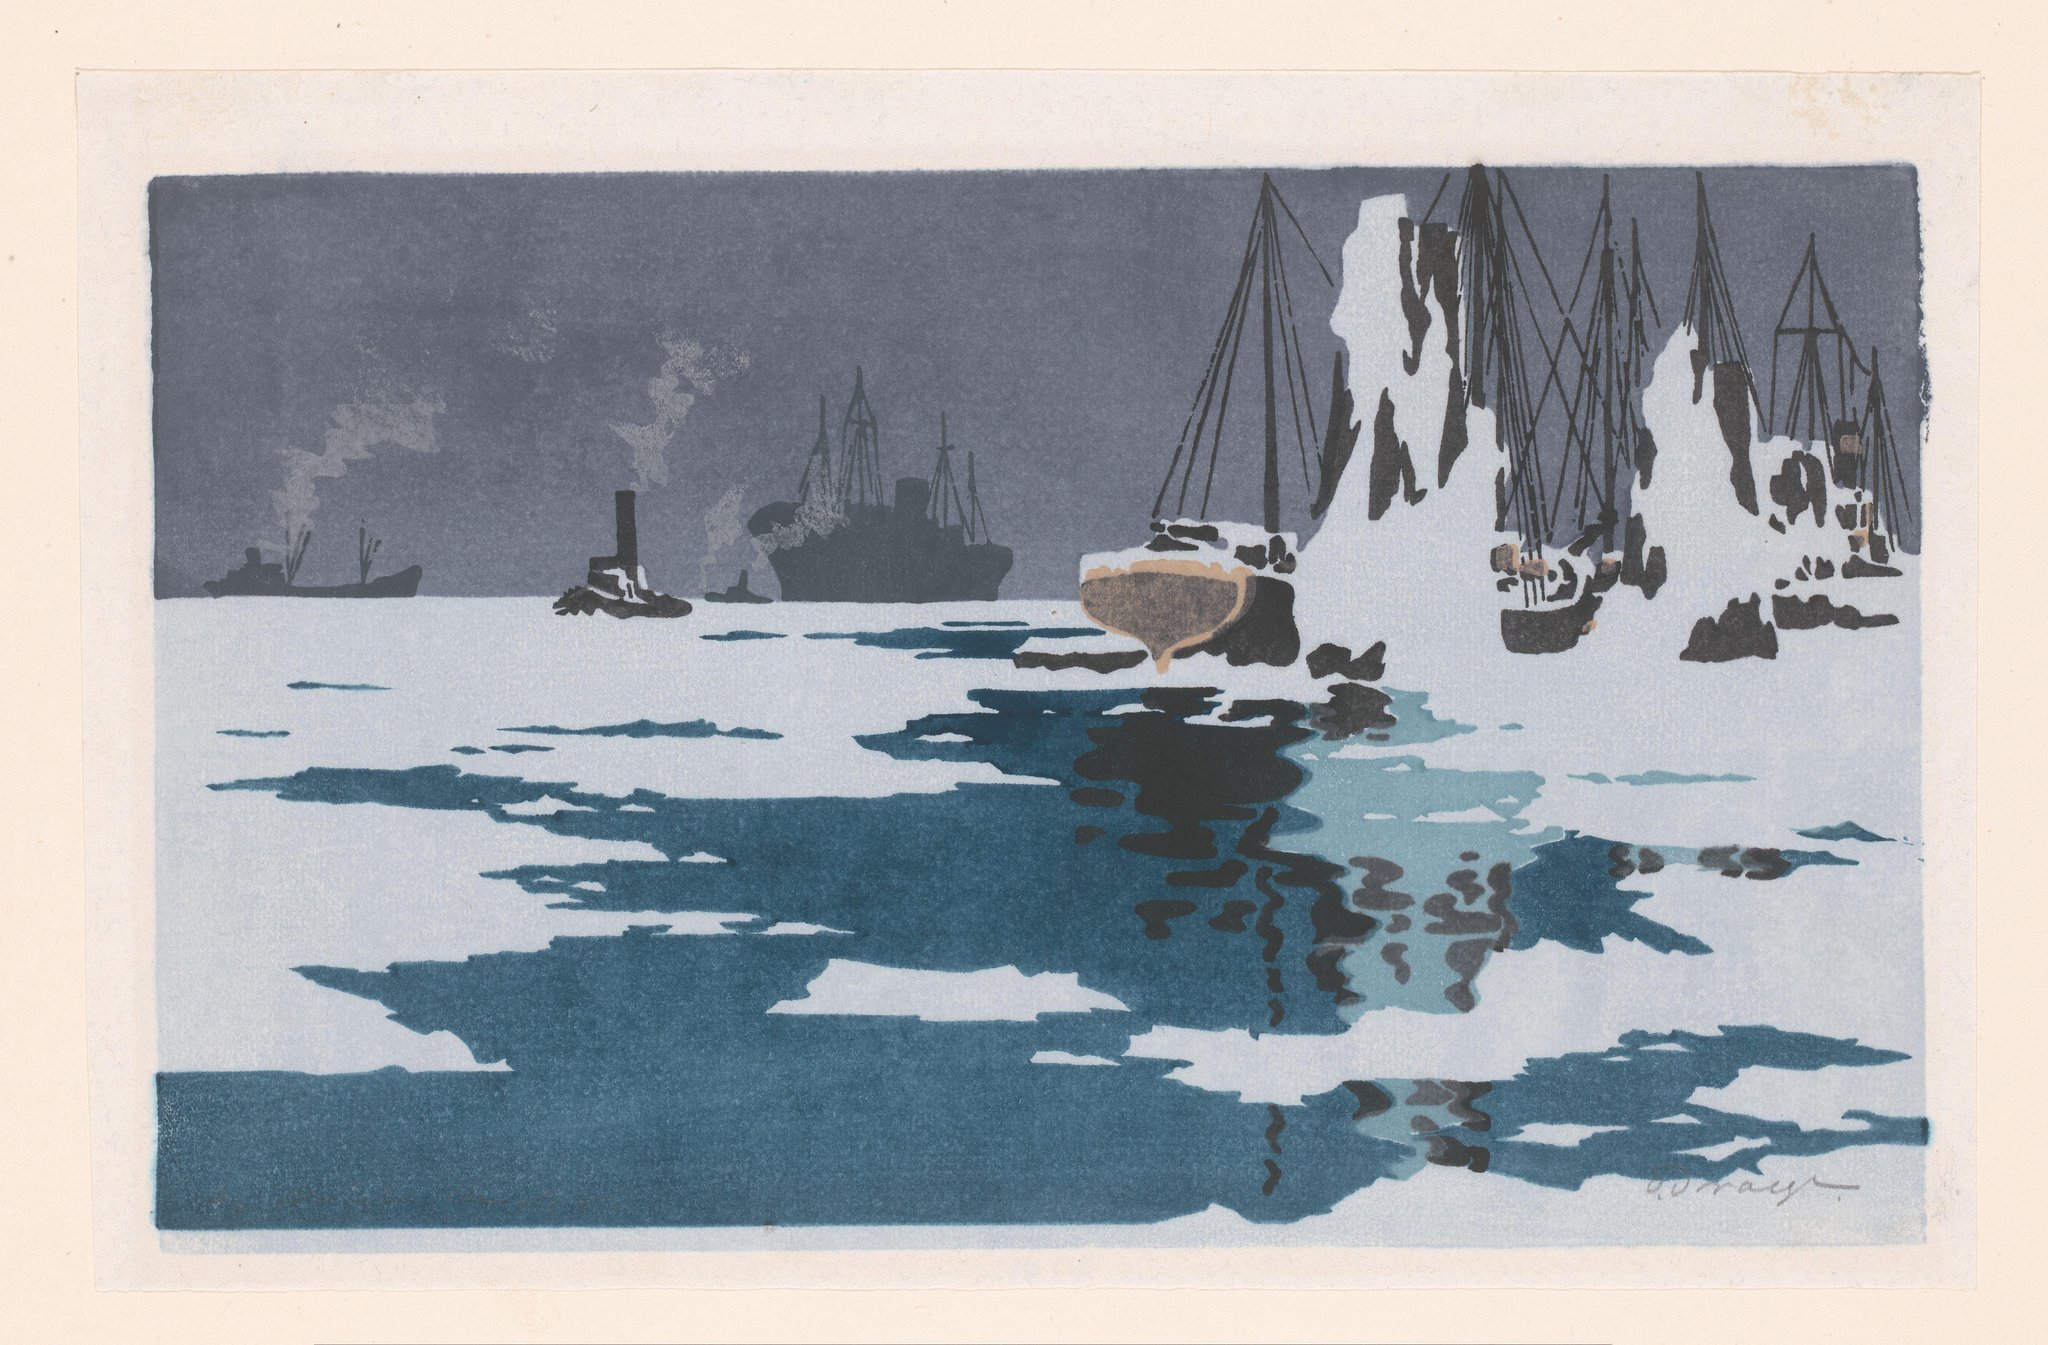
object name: print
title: Gezicht op Bremerhaven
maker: o. droegl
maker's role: print maker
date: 1900-1931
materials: paper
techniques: woodcut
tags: harbour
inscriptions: collector's mark: Lugt 2228